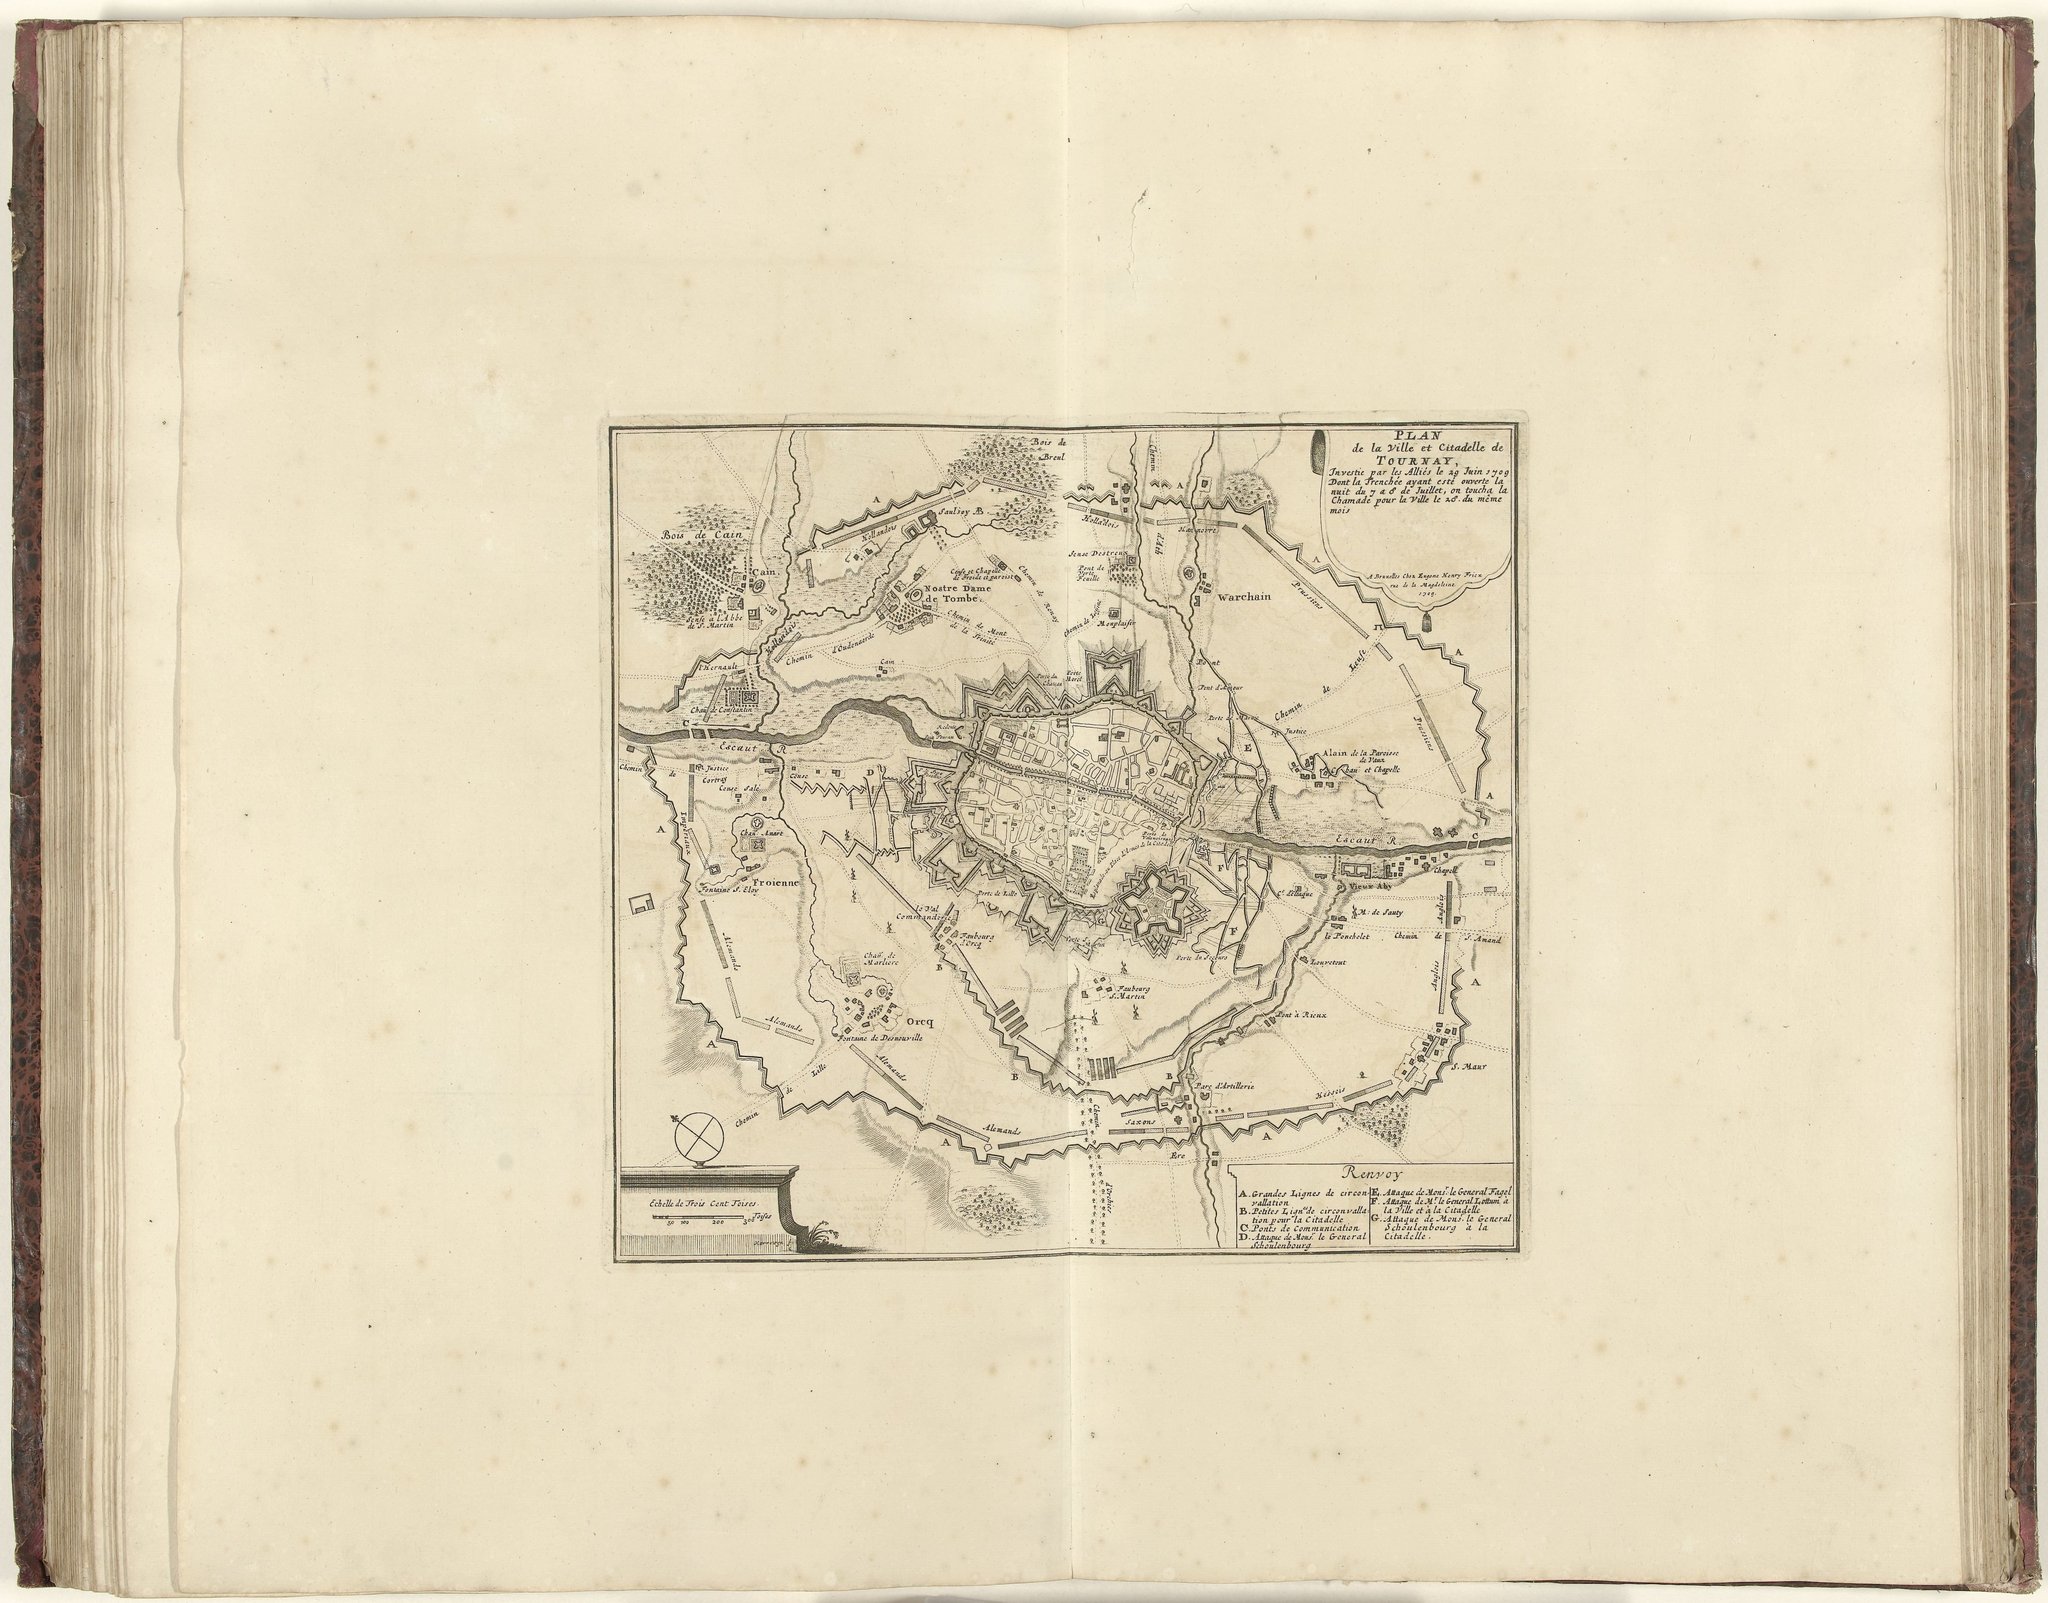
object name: map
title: Plan de la Ville et Citadelle de Tournay, Investie par les Alliés le 29 Juin 1709 Dont la Trenchée ayant esté ouvete la nuit du 7 a 8 de Juillet, on tocha la Chamade pour la Ville le 28. du même mois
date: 1709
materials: paper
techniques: engraving, etching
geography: brussels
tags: siege, position war, maps of cities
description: Kaart van het beleg van Tournai. De stad belegerd door de Geallieerden vanaf 29 juni en ingenomen op 2 september 1709. Onderdeel van een gebundelde verzameling van plannen van veldslagen en steden vermaard in de Spaanse Successieoorlog.